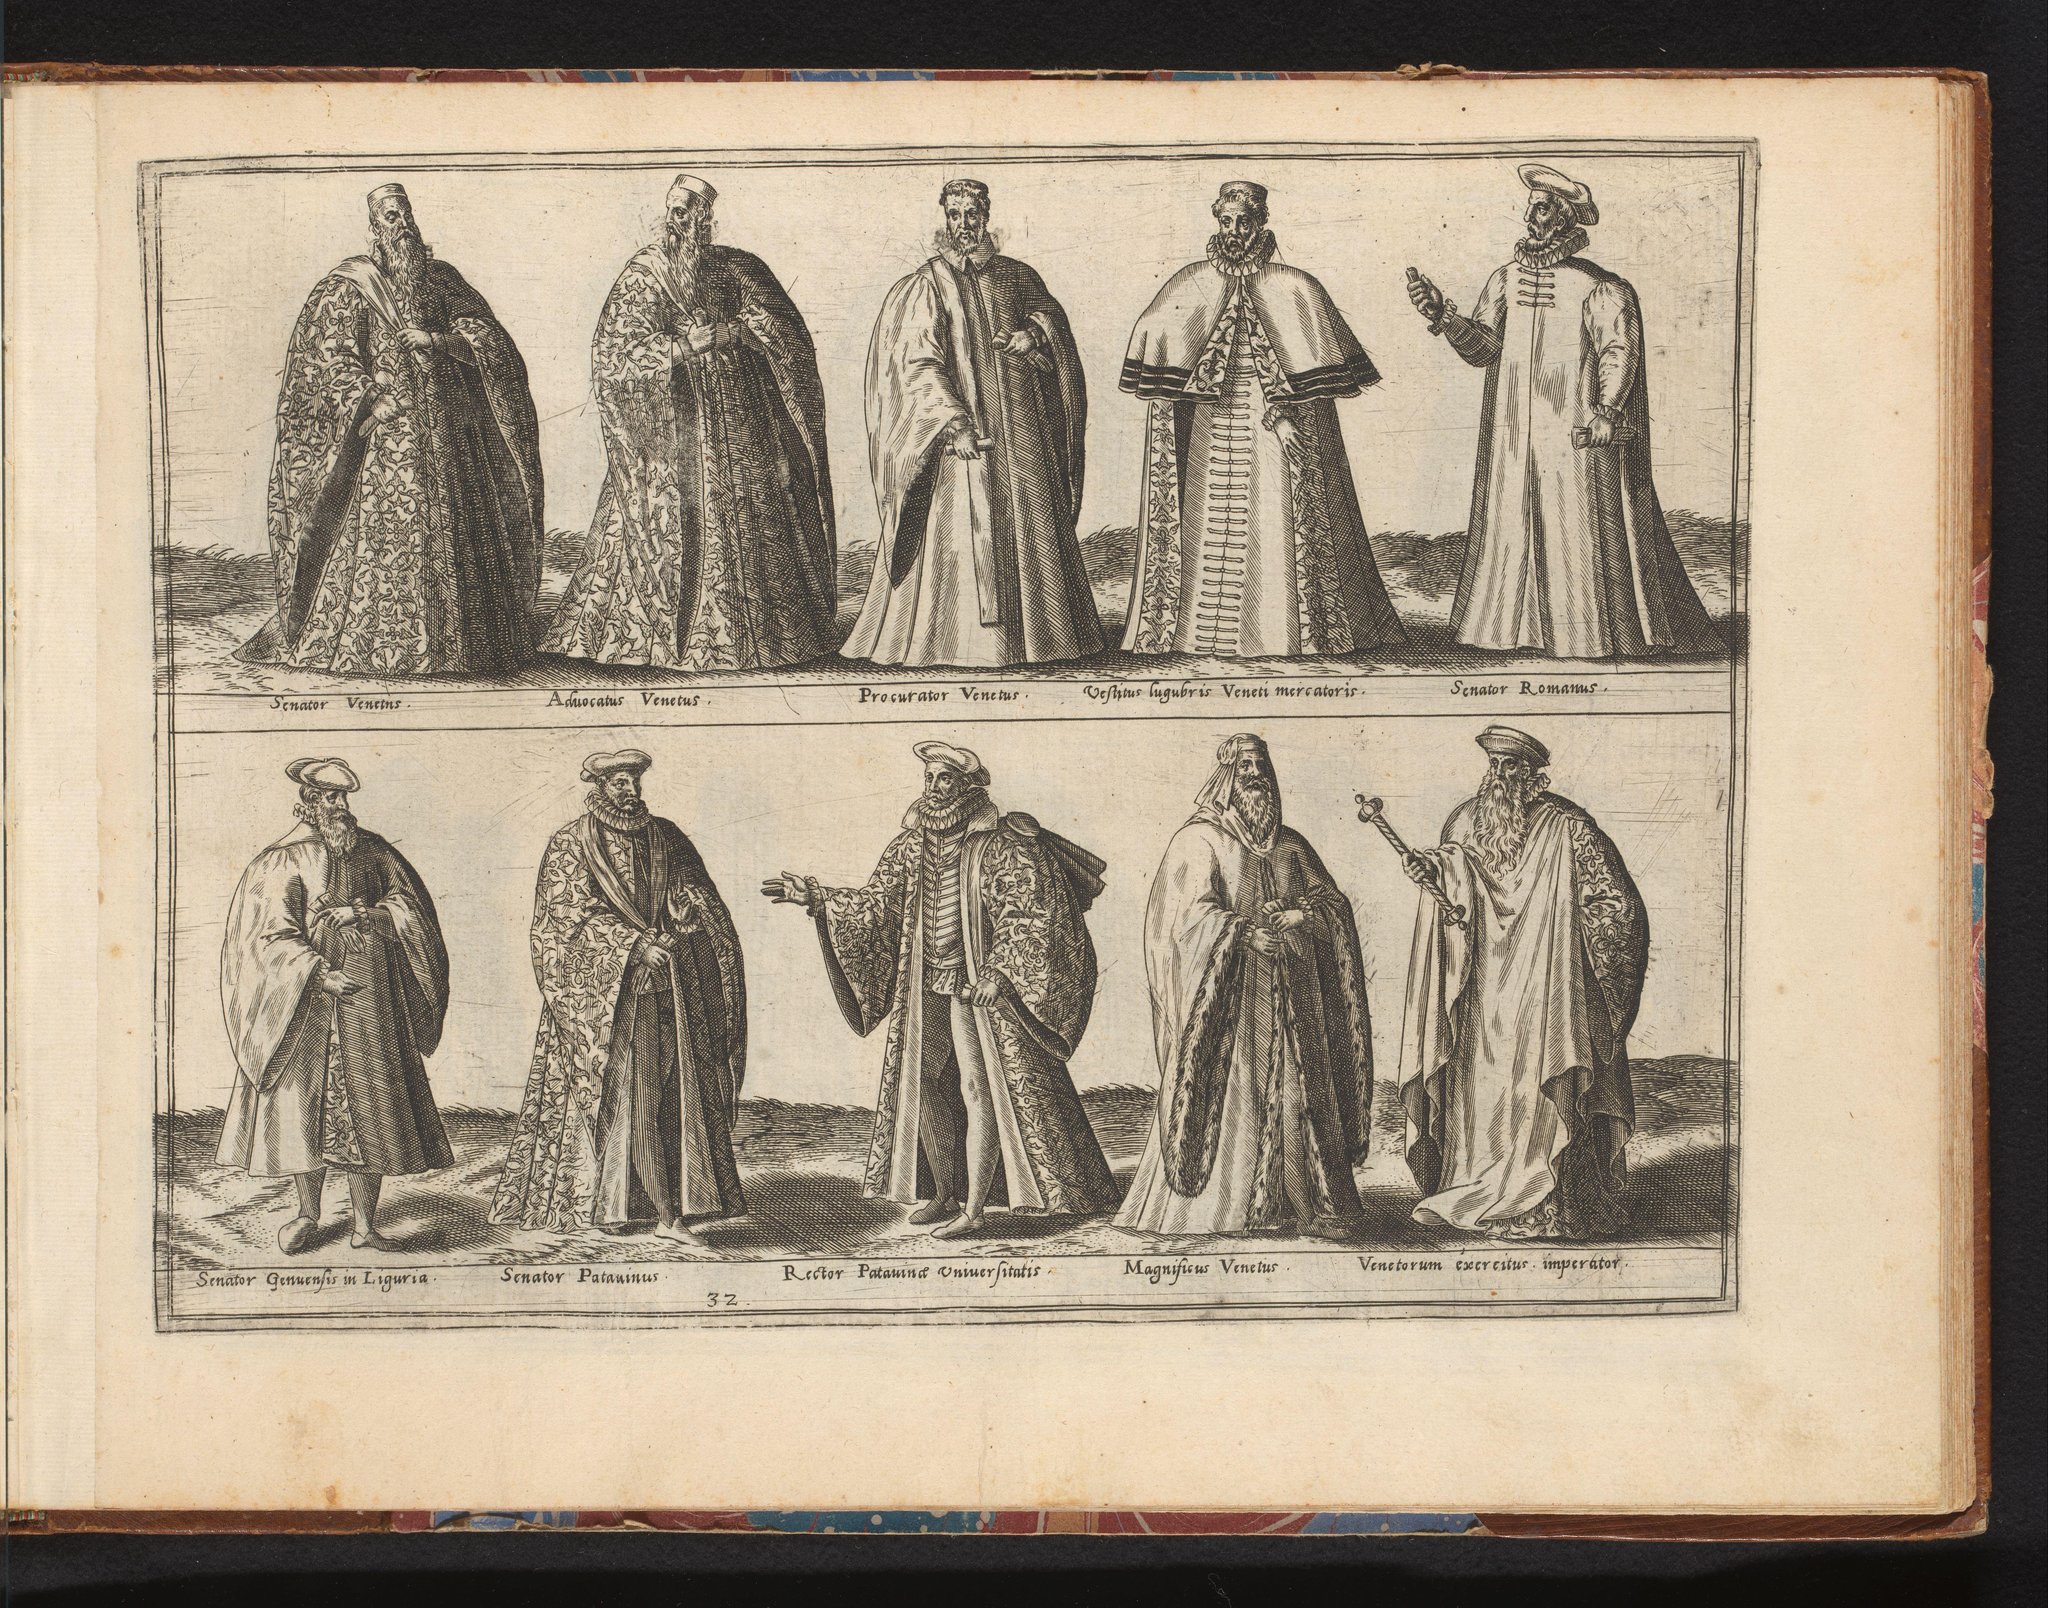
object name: album leaf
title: Tien mannen, gekleed volgens de Italiaanse mode van ca. 1580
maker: abraham de bruyn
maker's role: print maker, publisher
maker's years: 1540-1587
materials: paper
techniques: engraving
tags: europeans (italians) (+ men), other sovereign, clothes, costume (+ men's clothes), europeans (with name) (+ costume)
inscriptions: number: ‘32’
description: Tien senatoren, advocaten en andere hoogwaardigheidsbekleders, gekleed volgens de Italiaanse mode van ca. 1580. In twee rijen boven elkaar. Prent uit het boek 'Omnium pene Europae, Asiae, Aphricae atque Americae gentium habitus...', 1581. De prent maakt deel uit van een album.